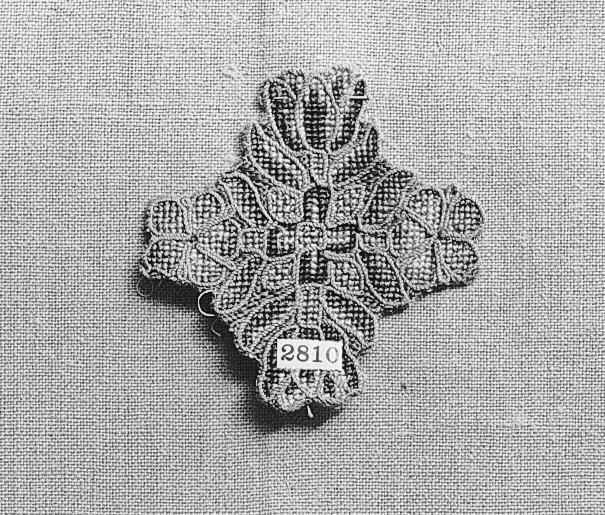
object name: ornament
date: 1801-1900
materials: canvas, silk